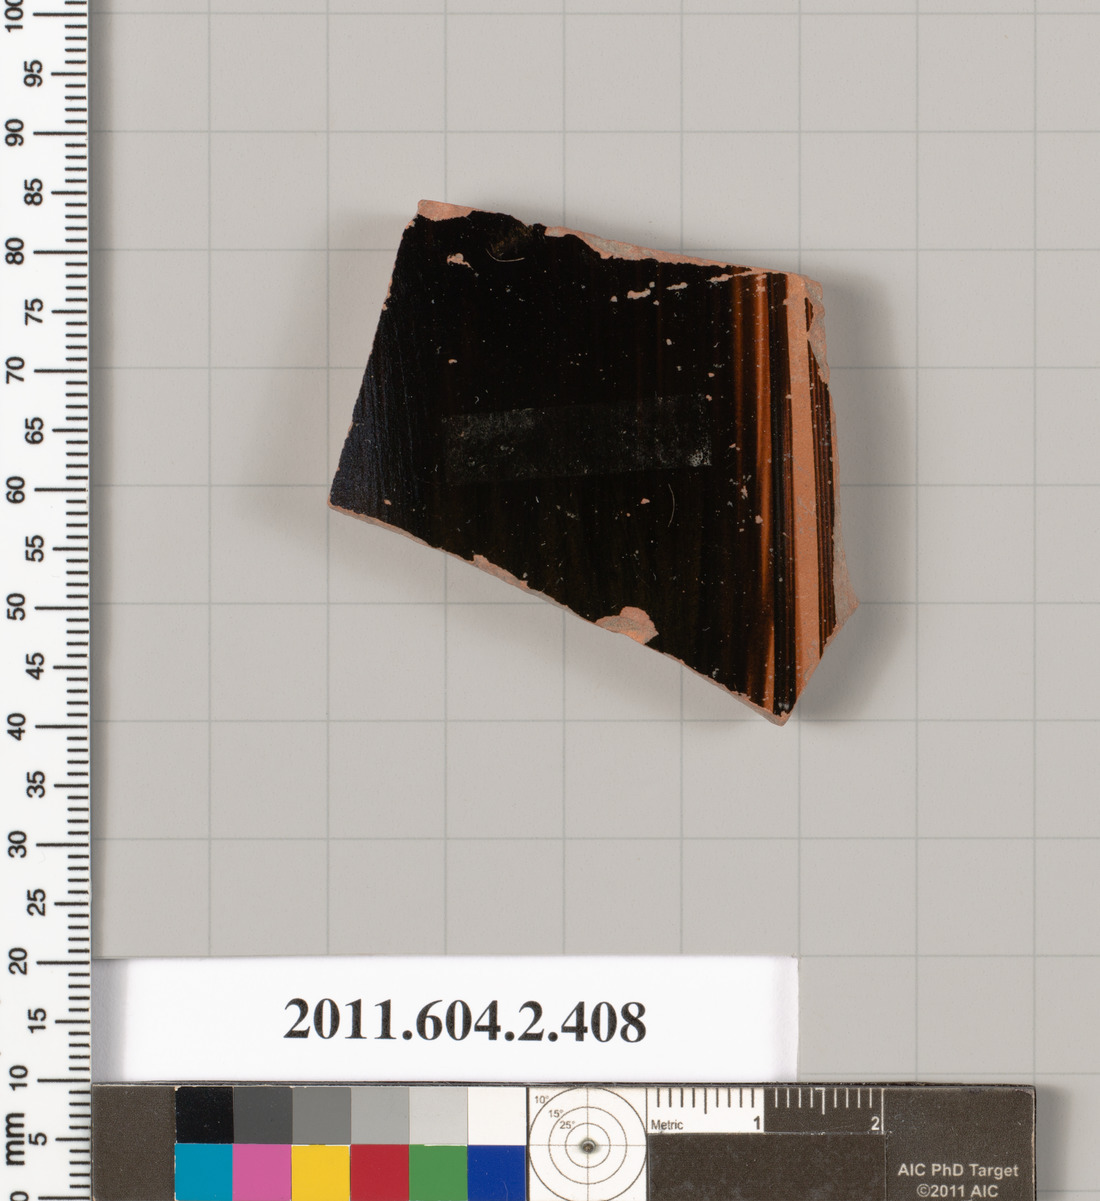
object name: column krater fragment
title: Terracotta fragment of a column-krater (bowl for mixing wine and water)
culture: greek, attic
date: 460-440 BCE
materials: terracotta